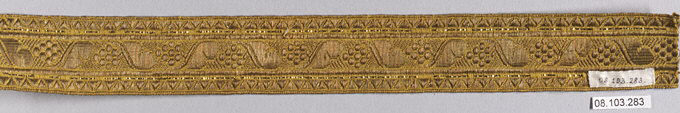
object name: galloon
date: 1601-1800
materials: metal thread, silk